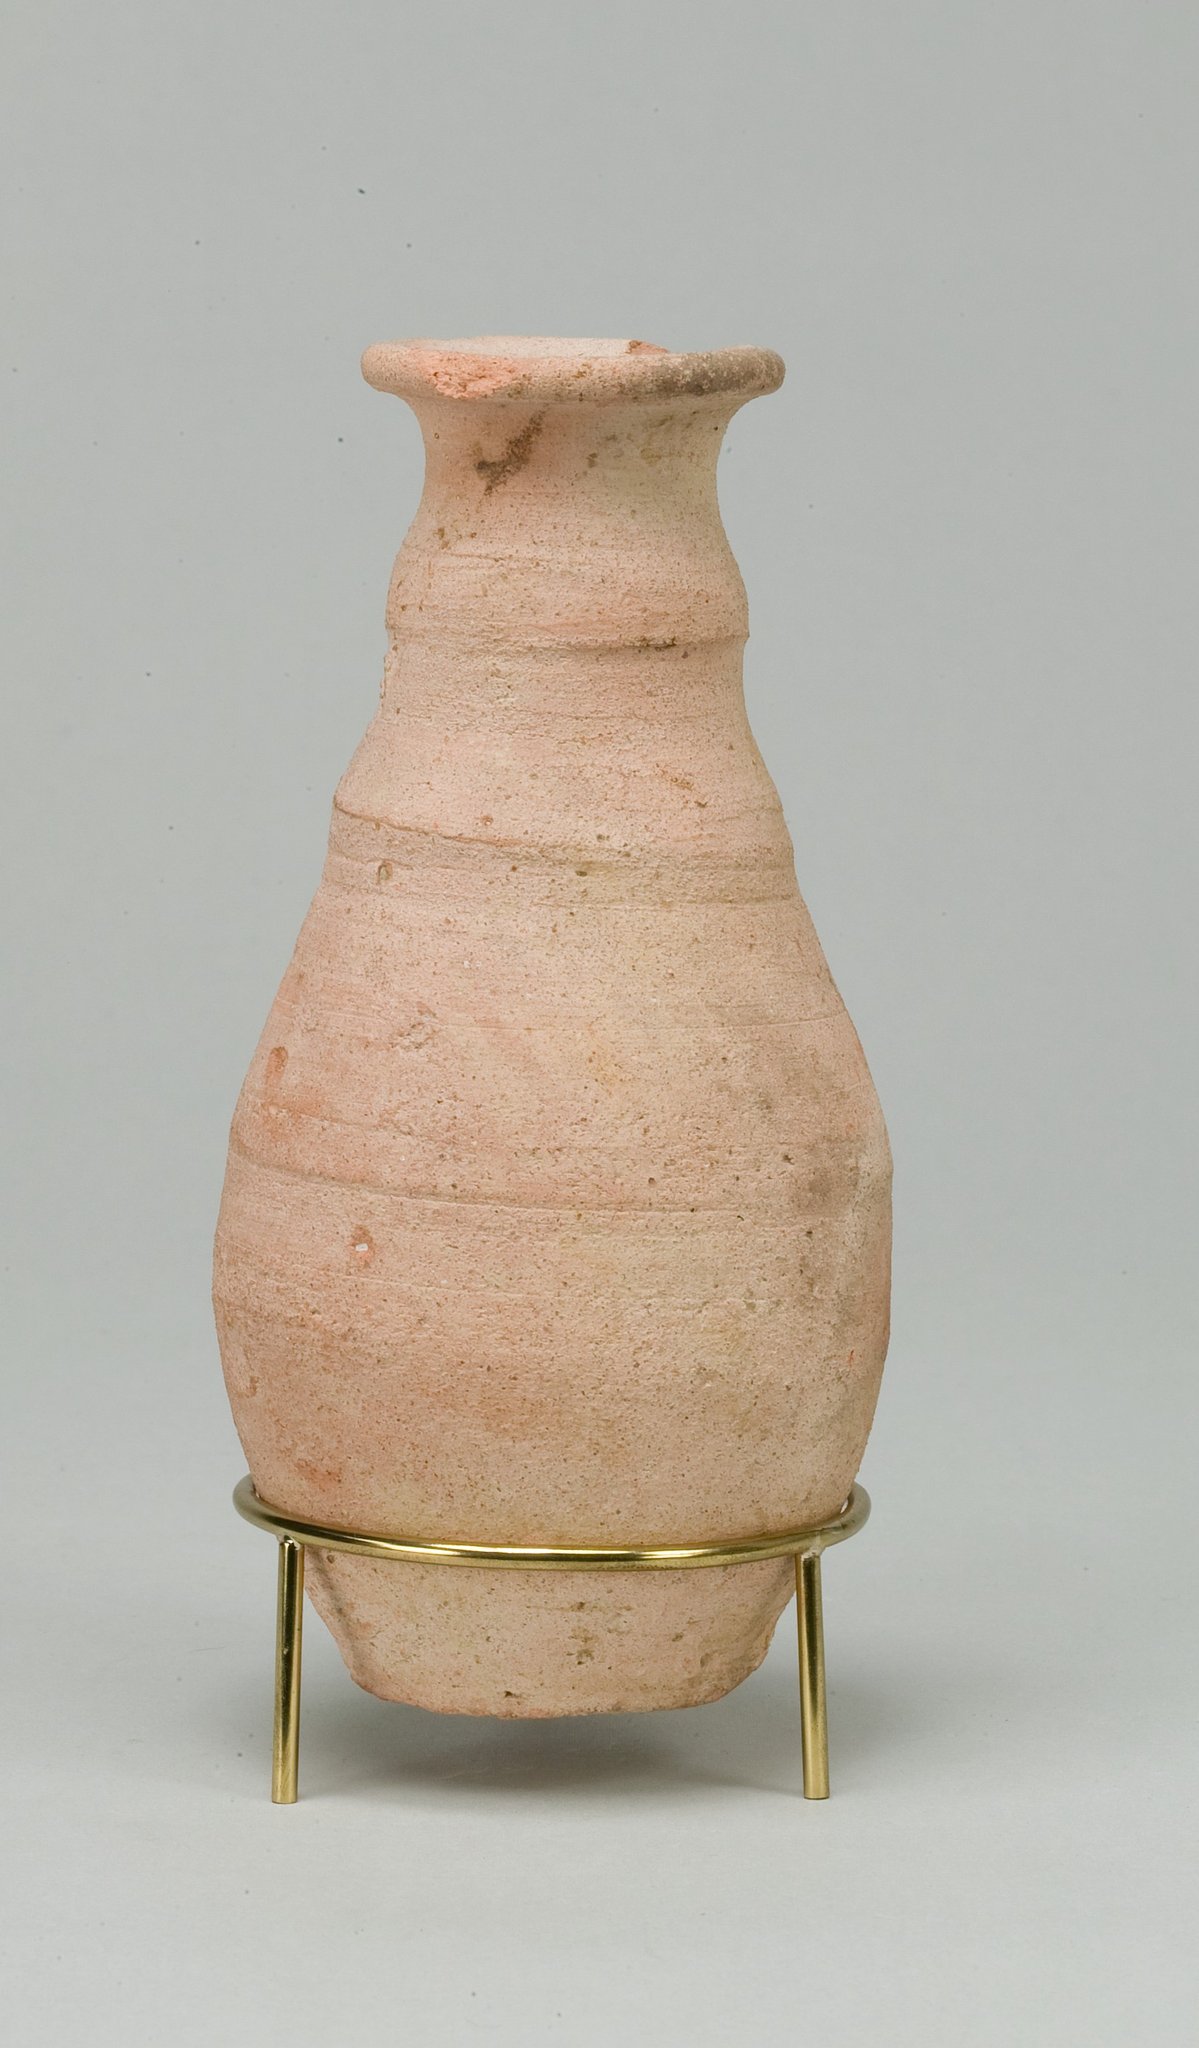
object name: vase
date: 1500-1400 BCE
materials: pottery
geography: egypt